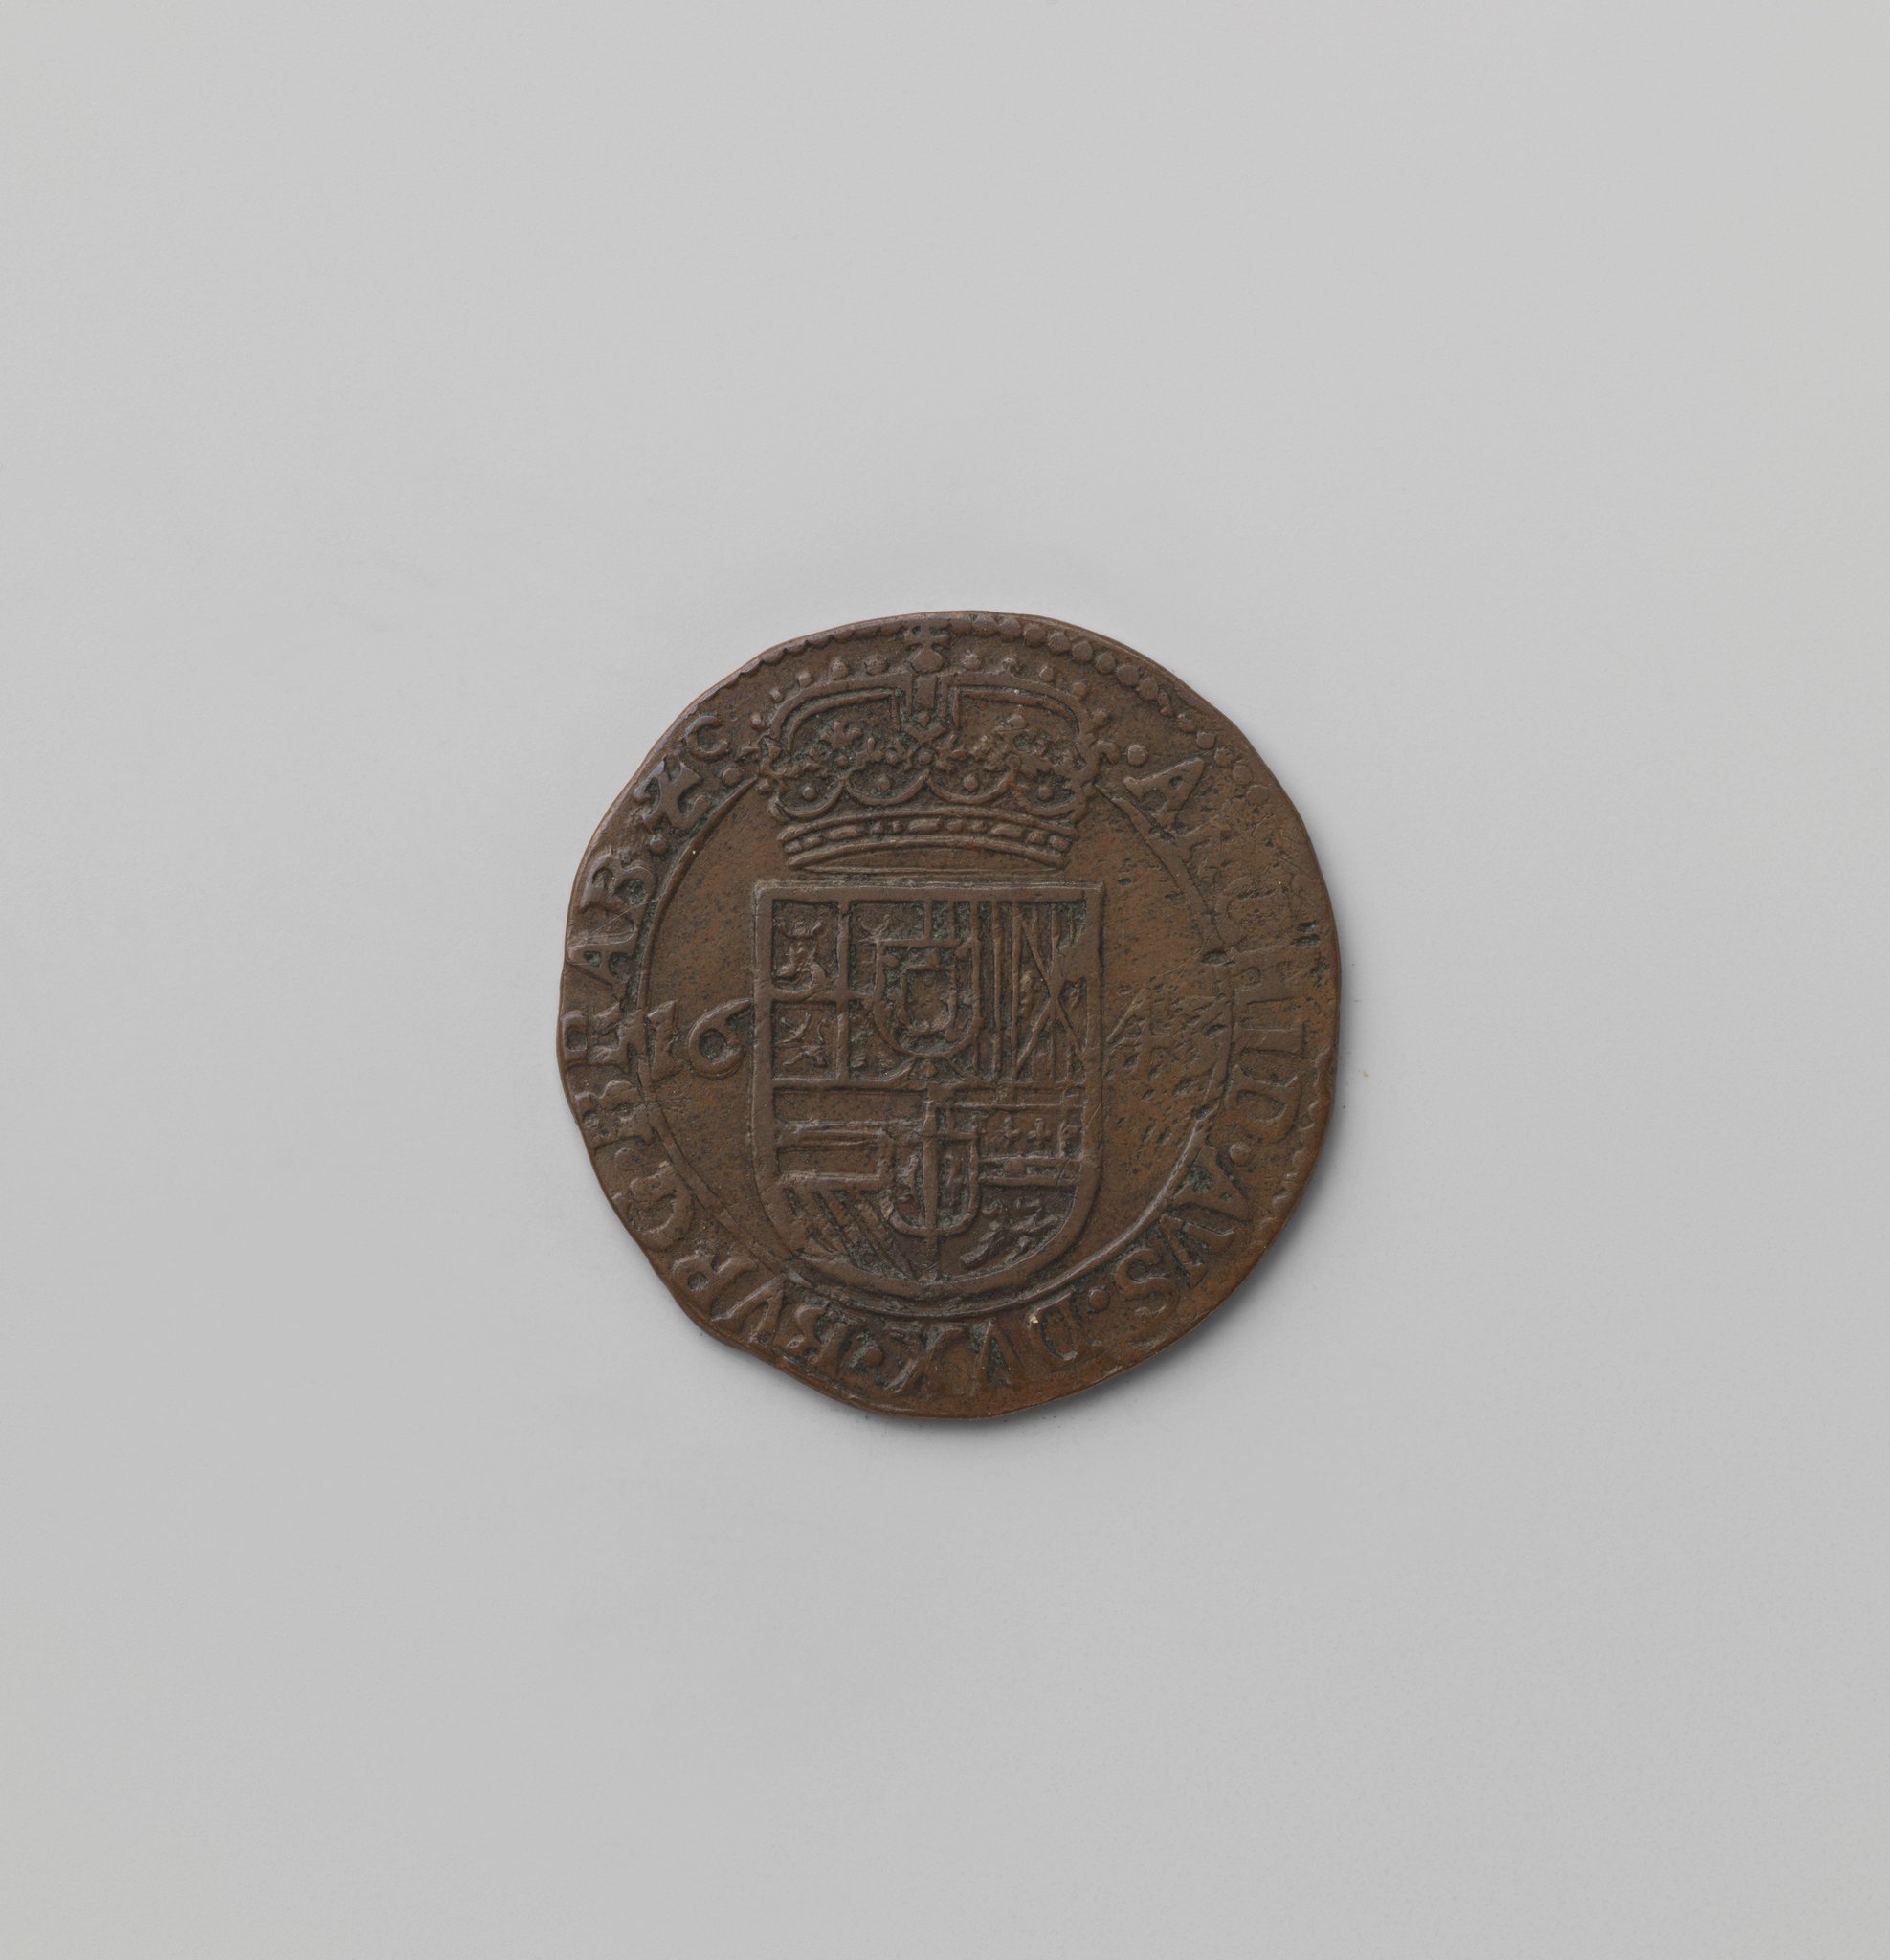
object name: oord, oortje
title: Oord uit Brabant van Philips IV, 1643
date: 1643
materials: copper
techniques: striking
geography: antwerp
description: Koperen munt. Voorzijde: tussen jaartal gekroond samengesteld wapenschild. Keerzijde: onder kroon vuurijzer. links en rechts daarvan en daaronder wapenschild. Boven kroon hand.